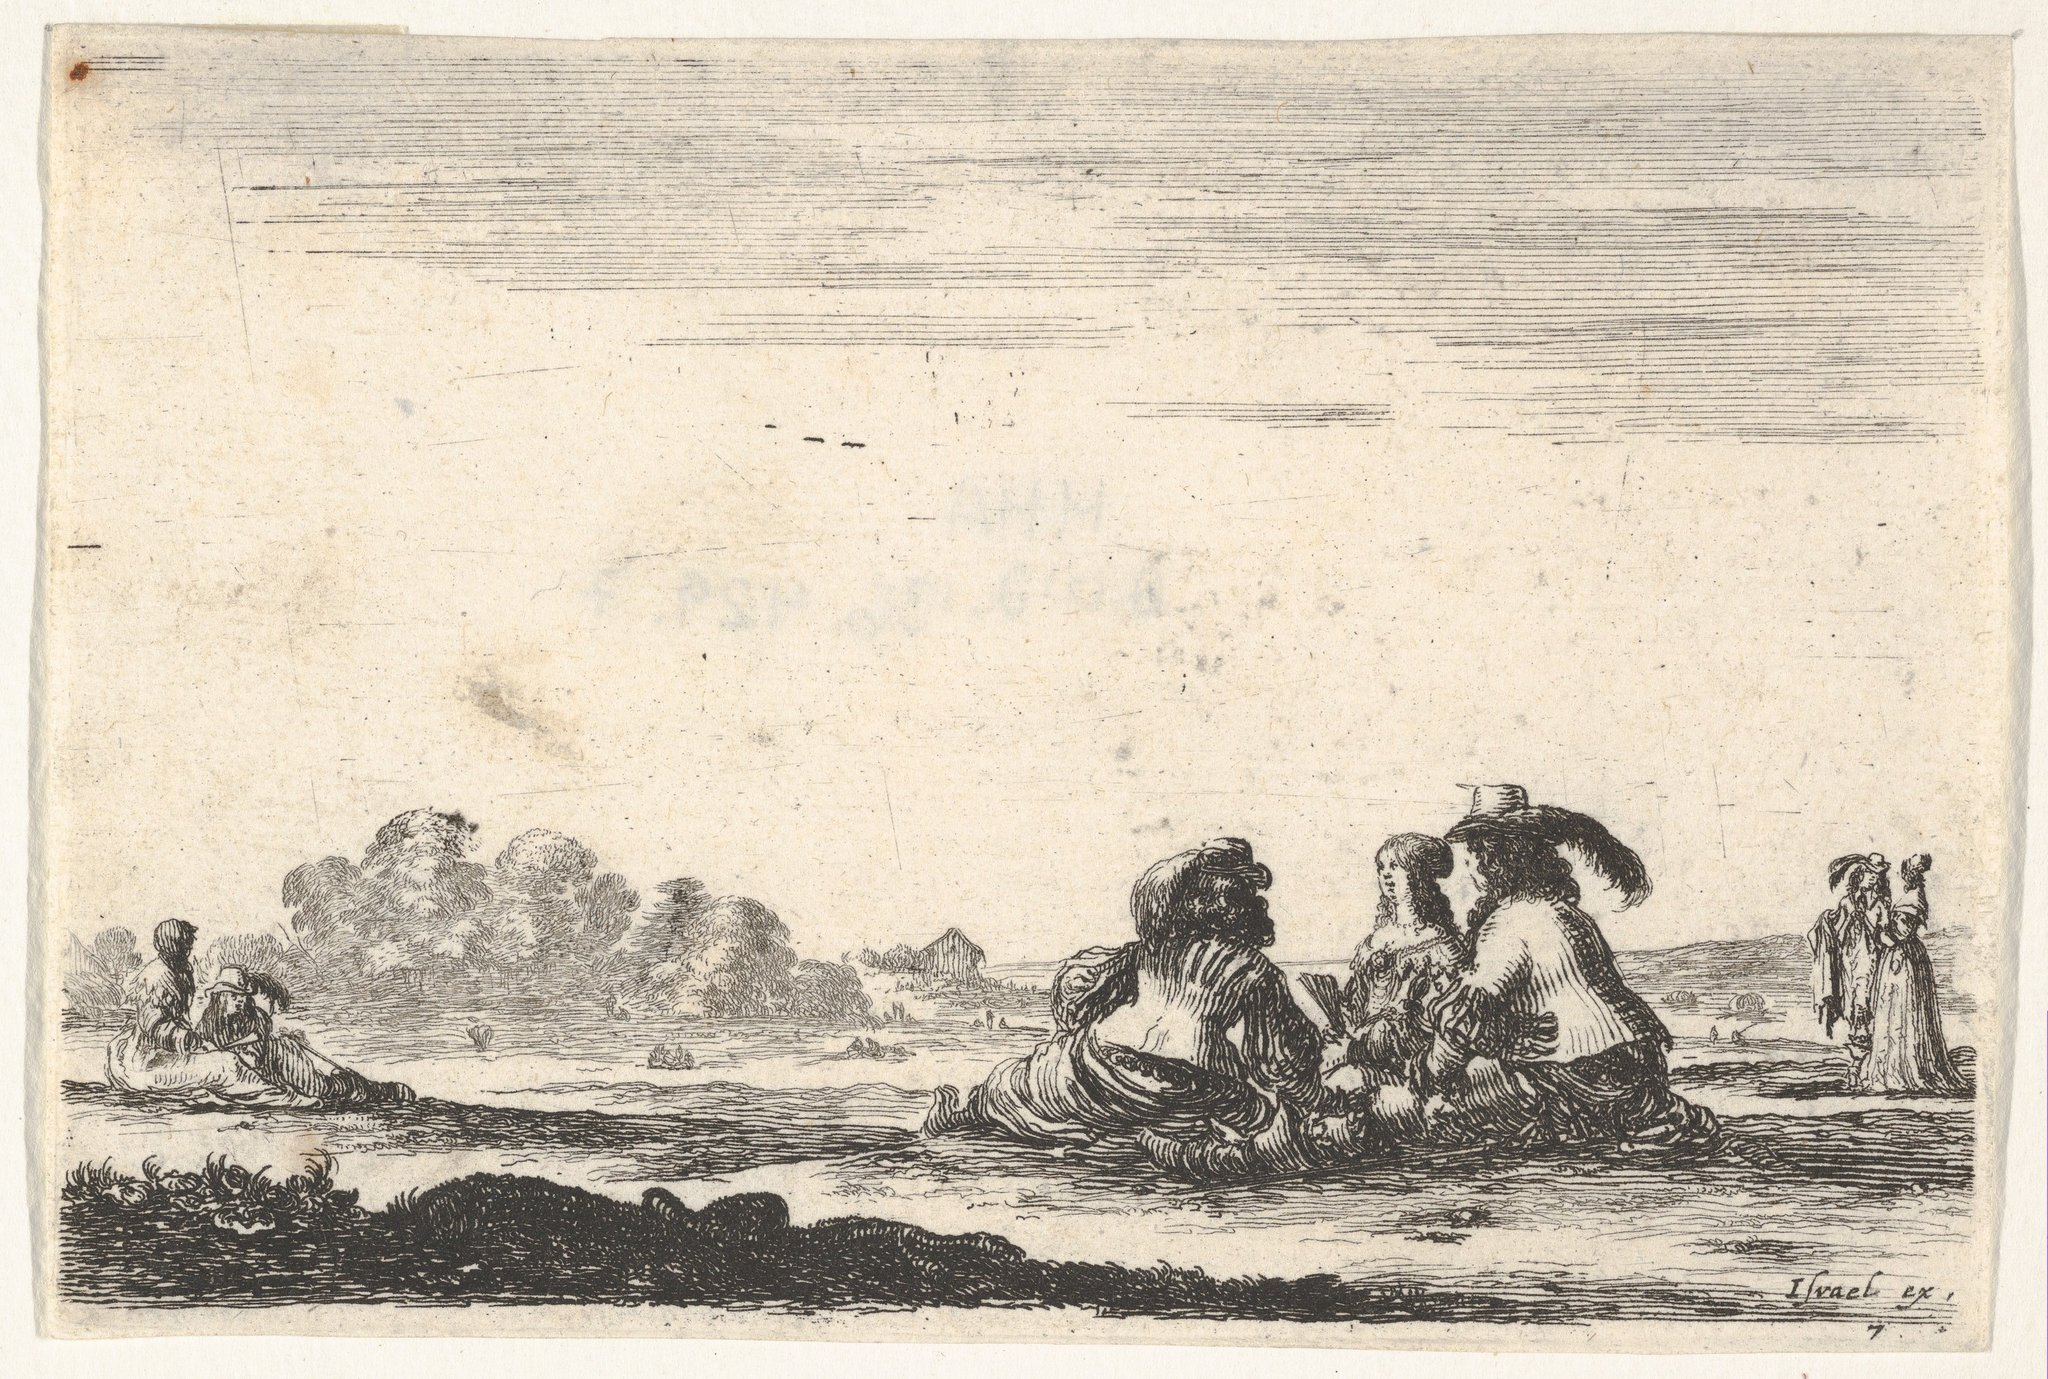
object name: print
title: Plate 7: Two noblemen seated in center, seen from behind, conversing with a noblewoman seated between them, a noblewoman and man seated to left in background and standing to right in background, from "Various Figures" (Agréable diversité de figures)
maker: stefano della bella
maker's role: artist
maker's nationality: italian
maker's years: 1610-1664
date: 1642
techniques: etching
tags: men,women